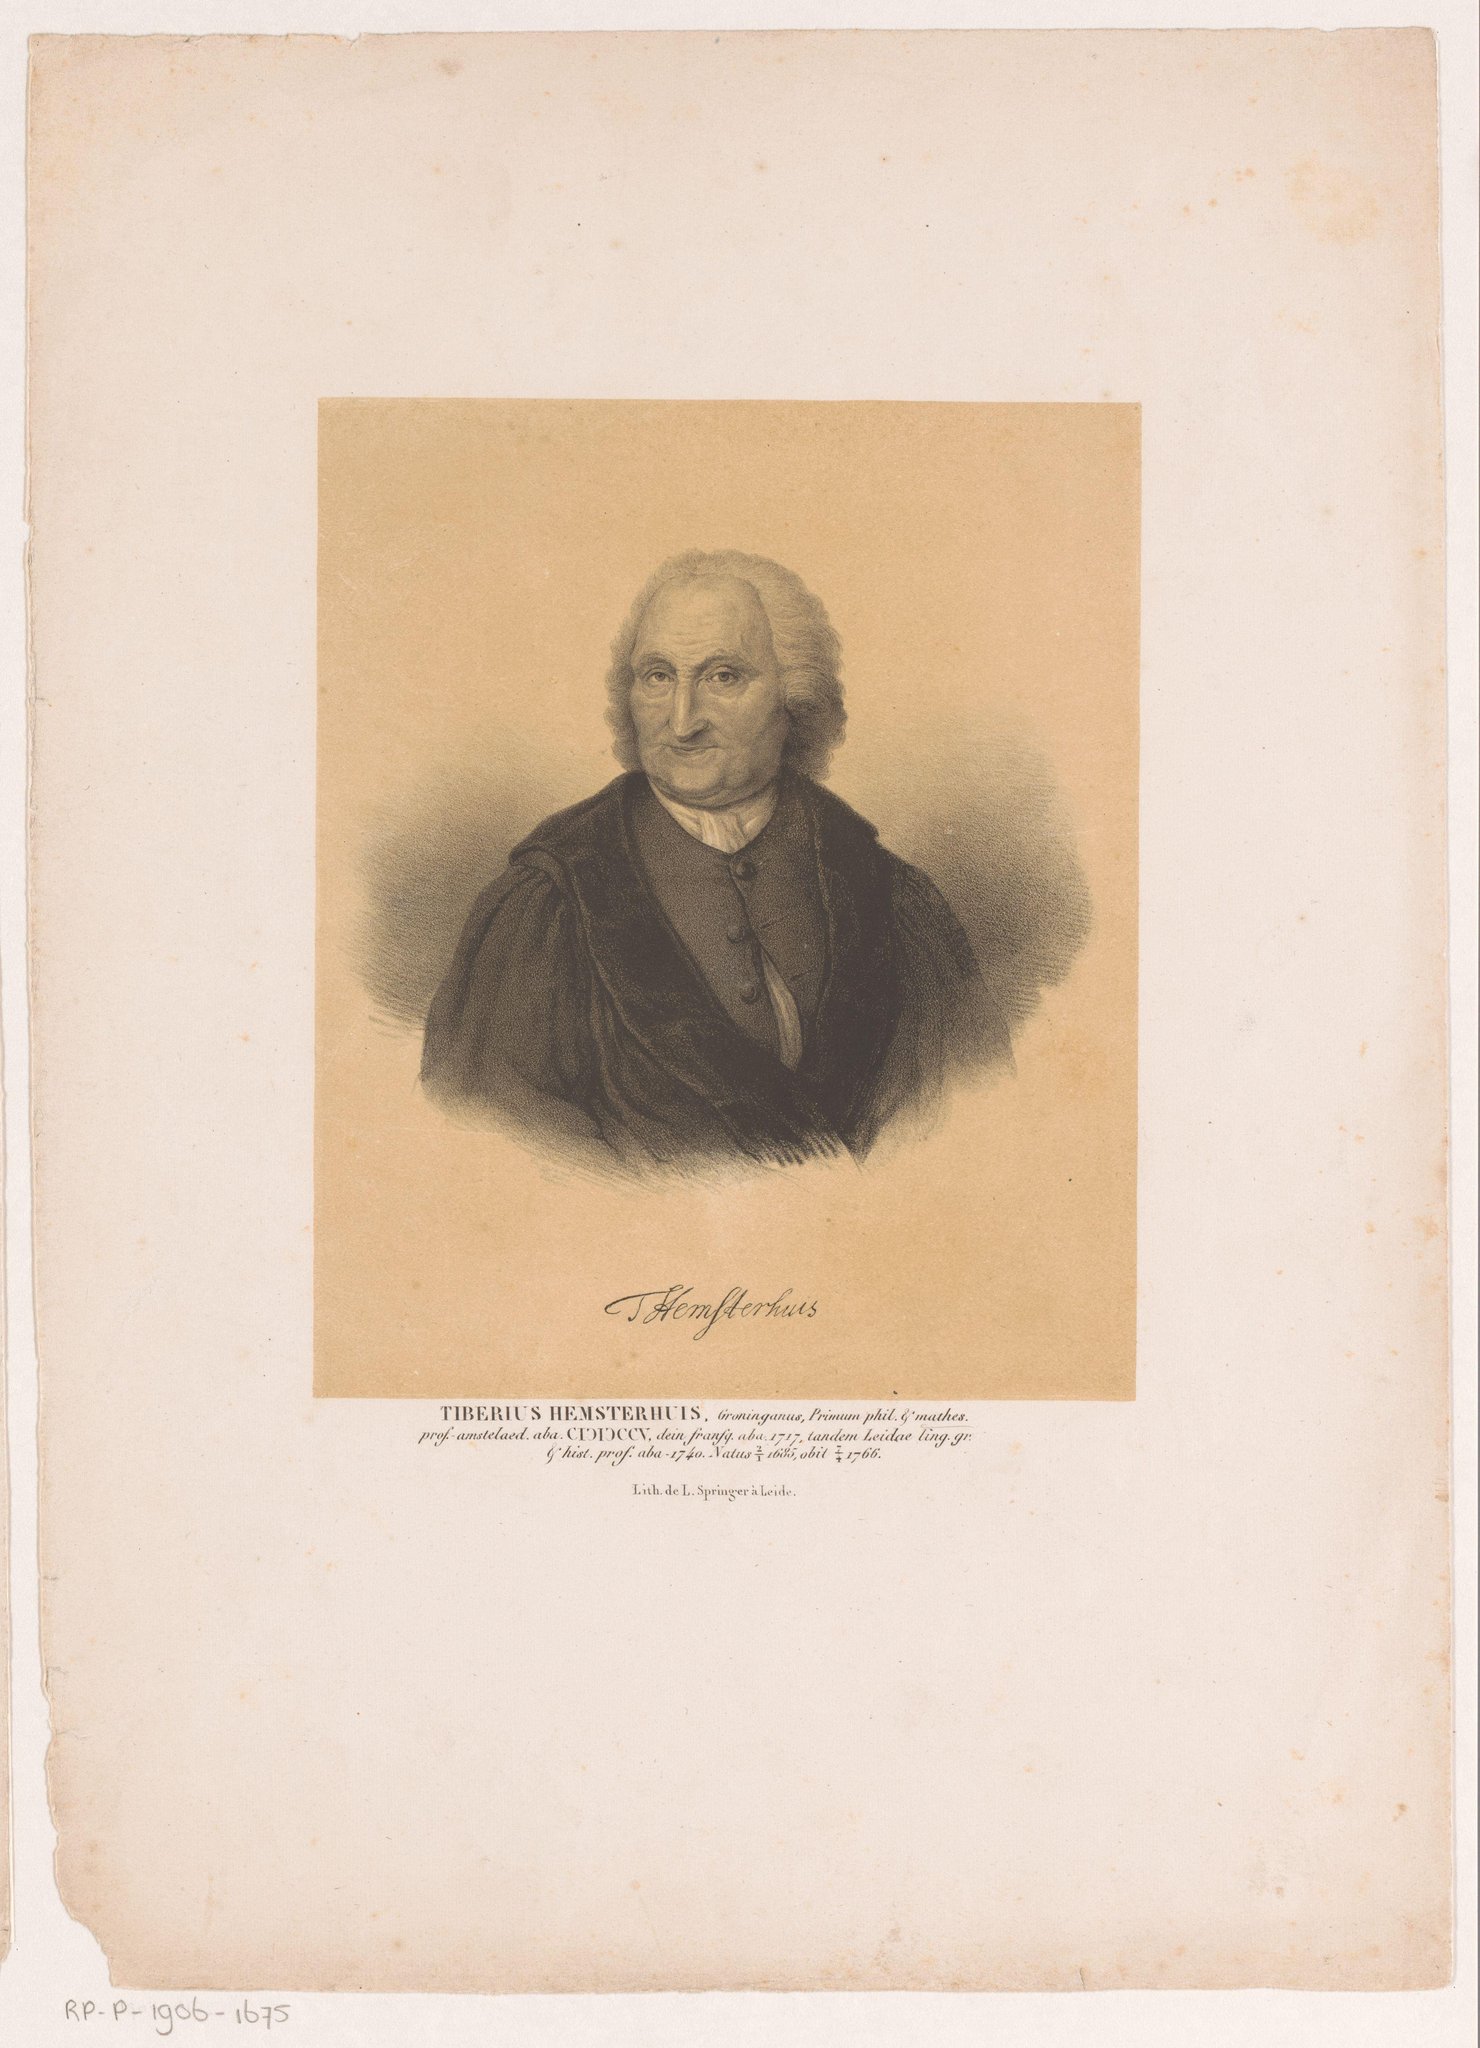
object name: print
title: Portret van Tiberius Hemsterhuis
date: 1809-1871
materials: paper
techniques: tone lithography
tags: historical persons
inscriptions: collector's mark: Lugt 2228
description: Onder het portret de signatuur en biografische gegevens van de geportretteerde.